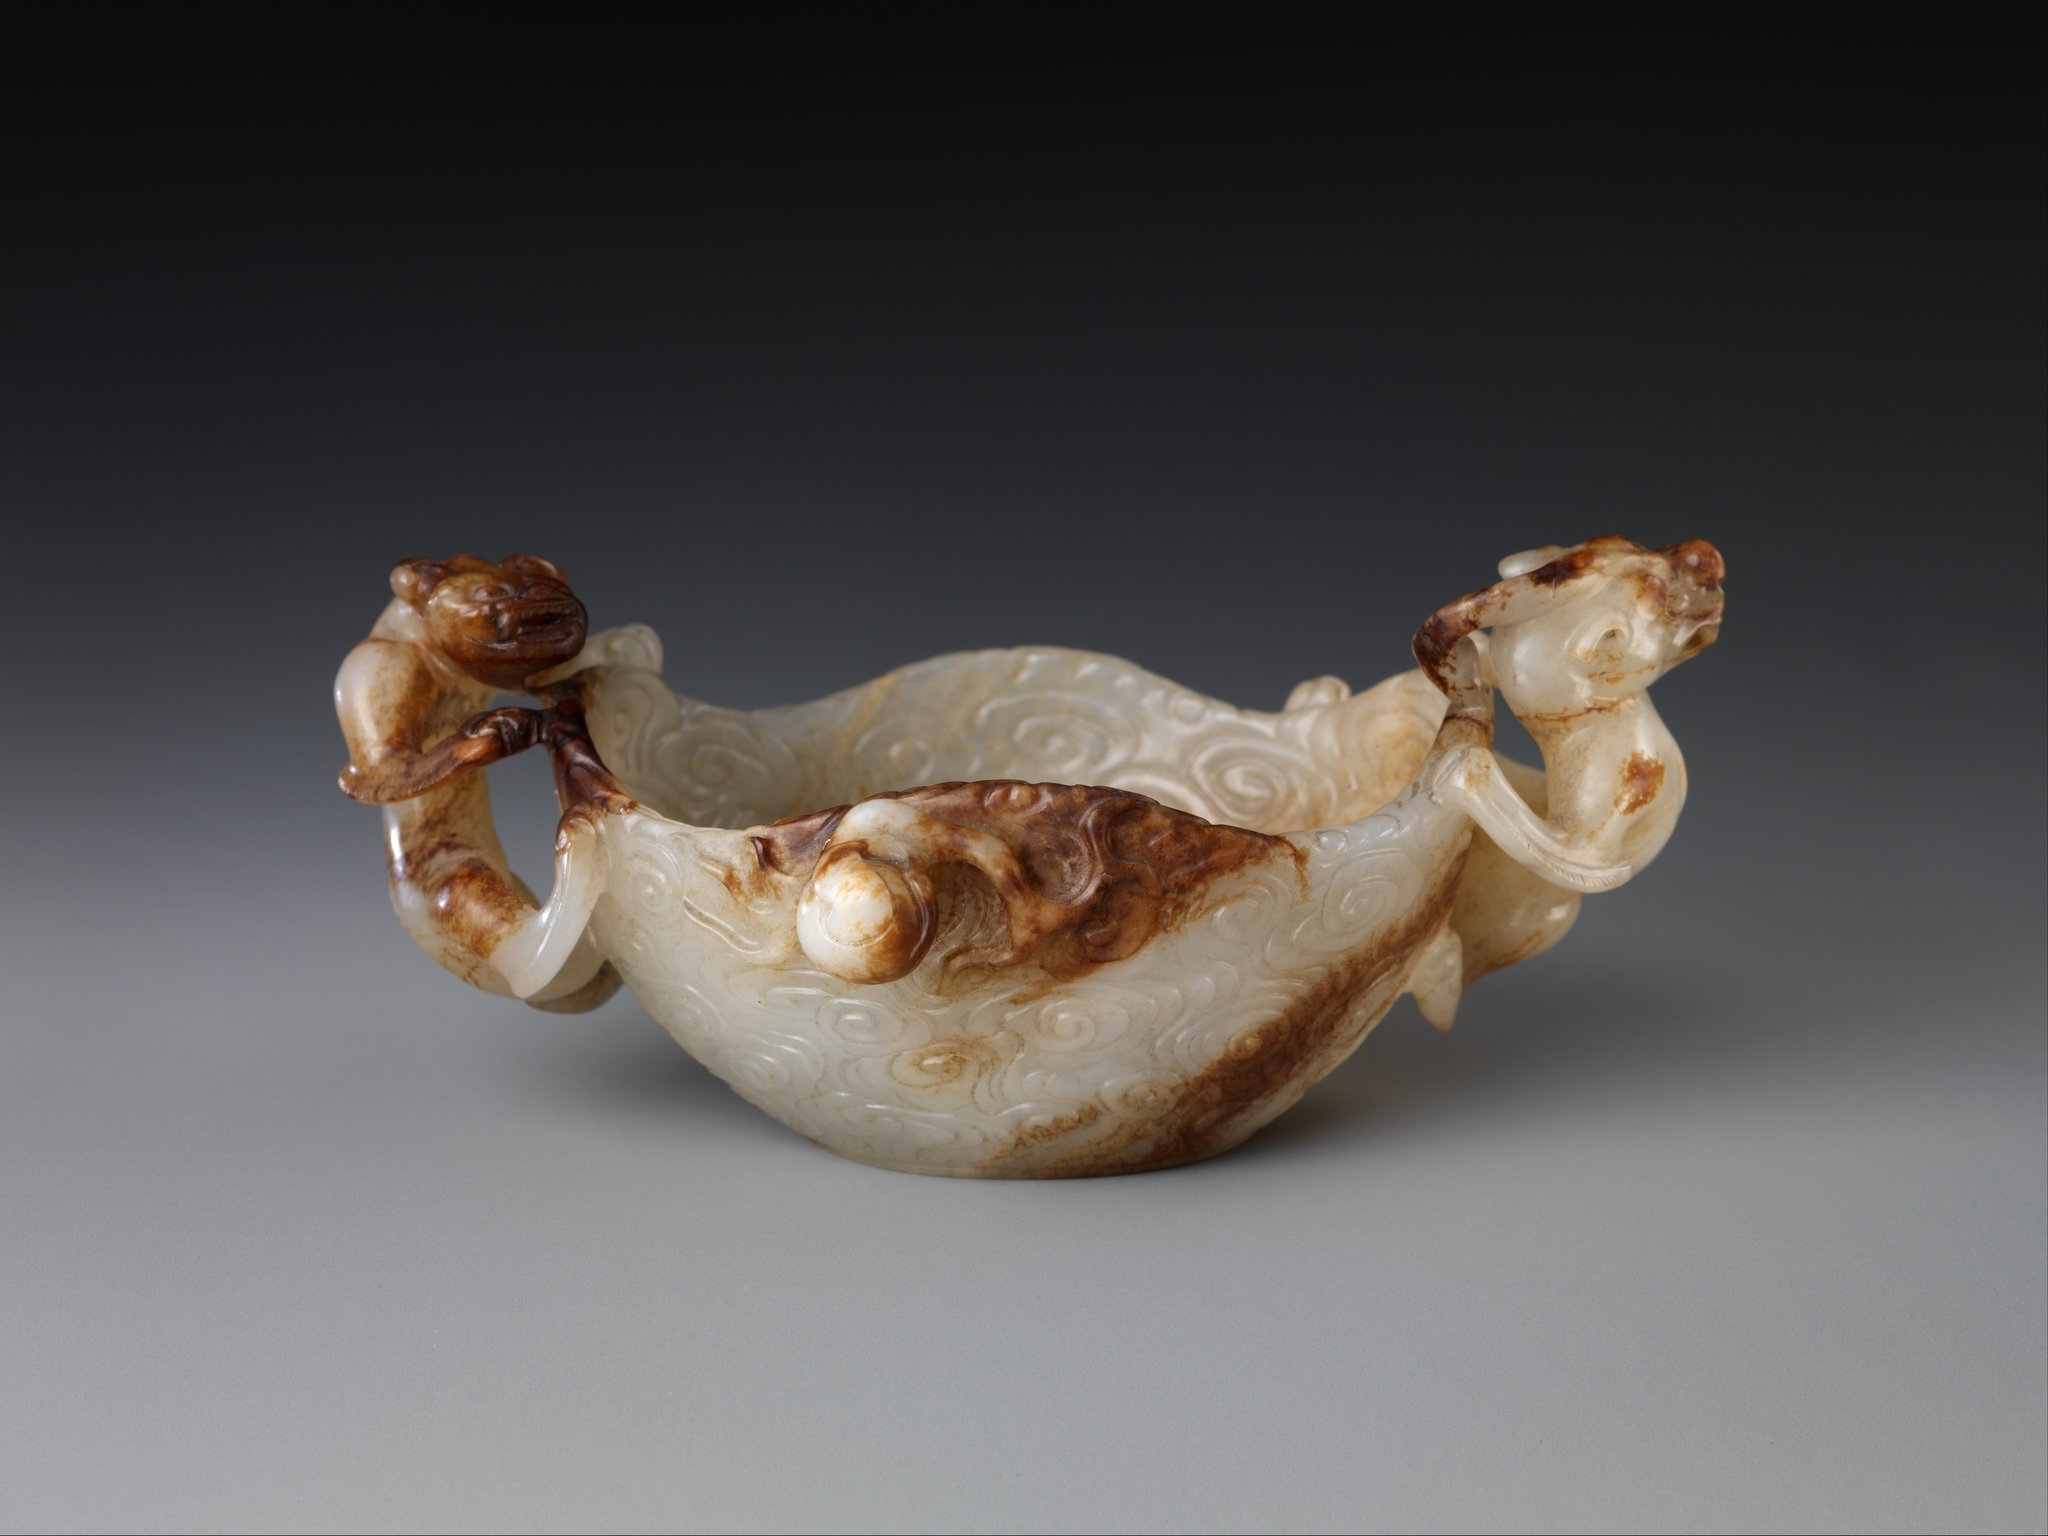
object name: cup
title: Oval cup with chi dragons amid clouds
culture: chinese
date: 1101-1400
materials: jade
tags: dragons